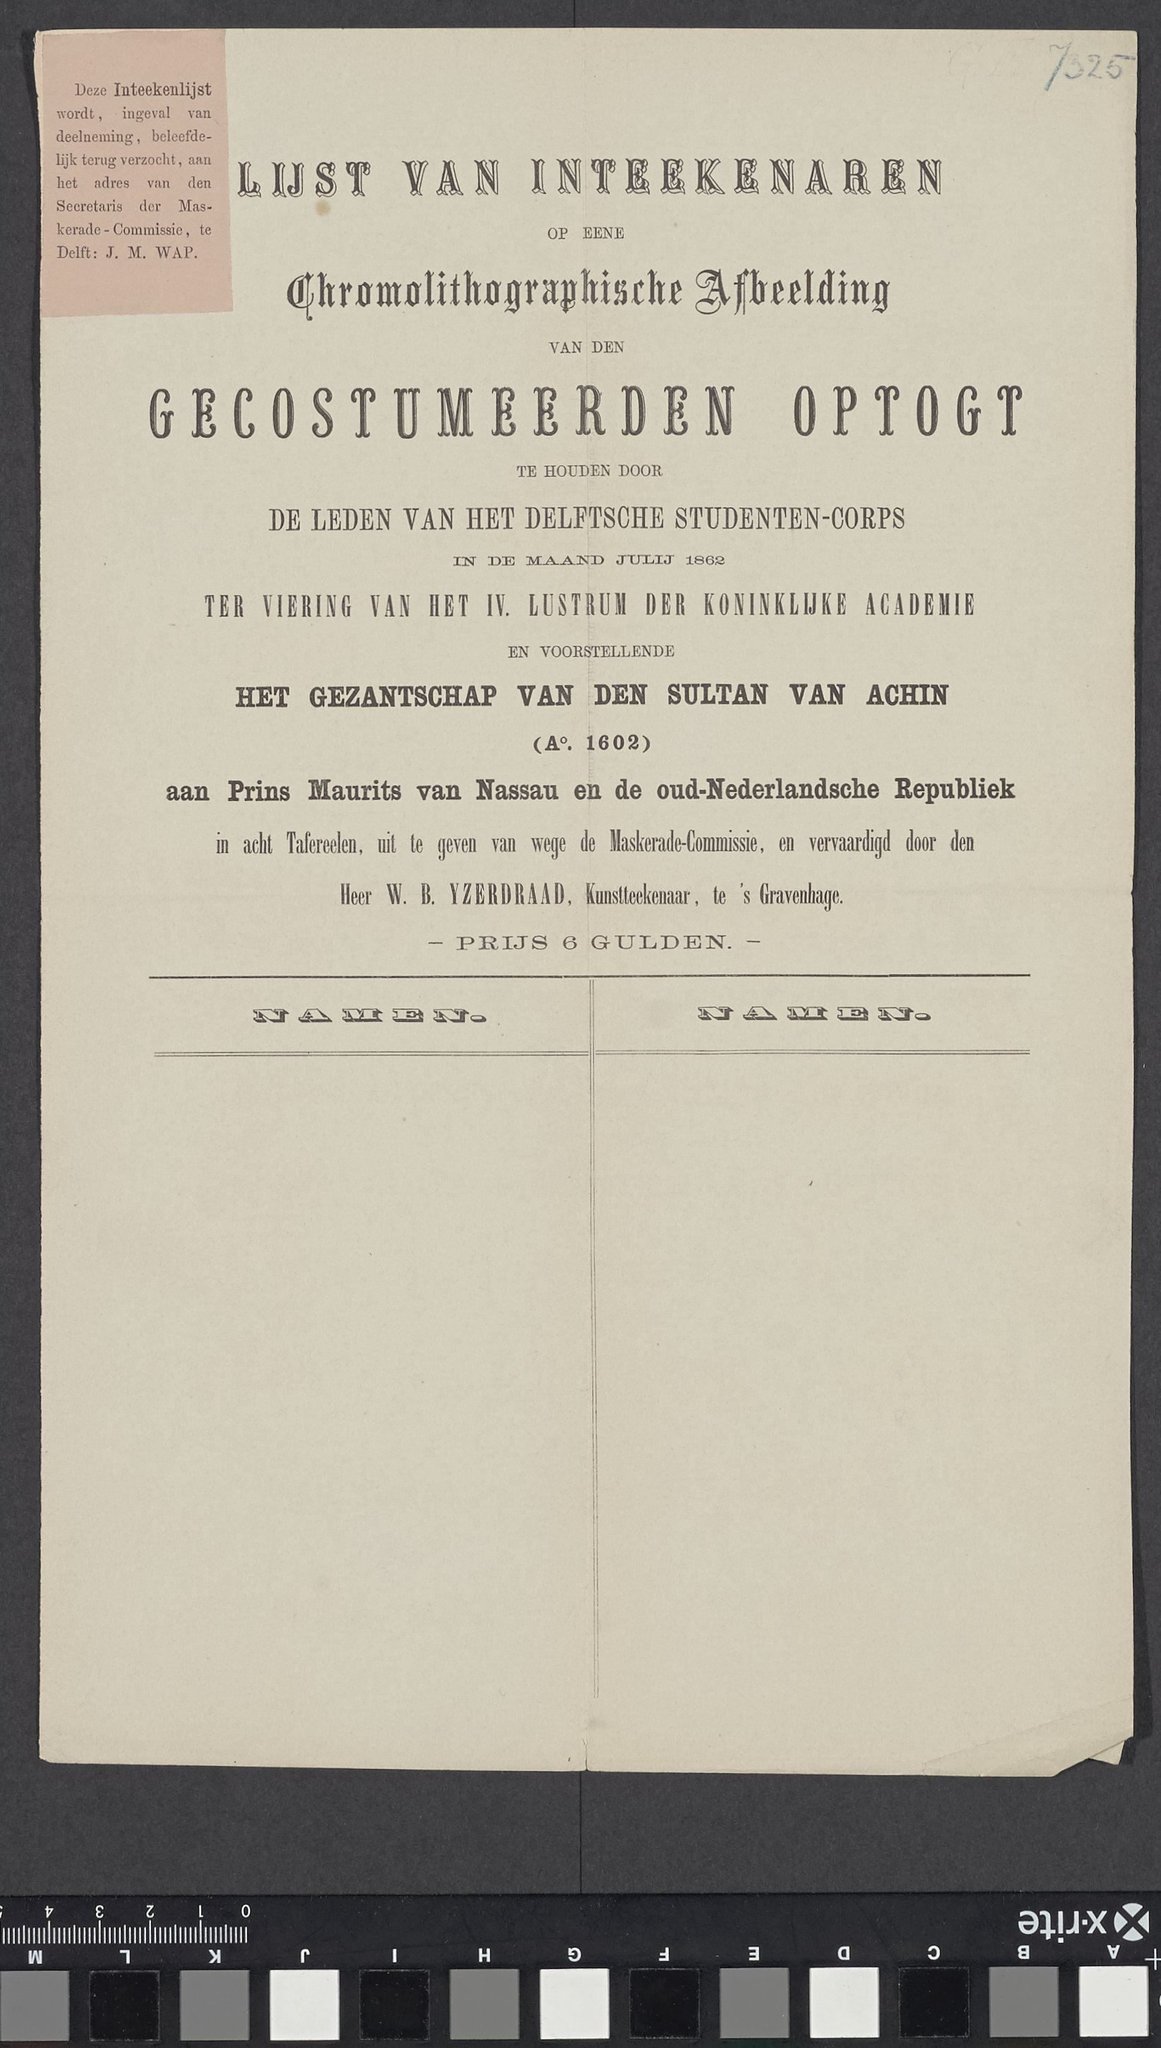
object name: text sheet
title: Vierde Lustrum der Koninklijke Academie te Delft - Ao. 1862 - Gekostumeerde Optogt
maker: Anonymous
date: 1862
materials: paper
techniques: letterpress printing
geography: netherlands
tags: university, students' pageant, commemoration of the founding of a university, delft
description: Blanco lijst van intekenaren. Behorend bij de serie van acht platen van de gekostumeerde optocht gehouden door de studenten van de Koninklijke Academie te Delft bij het vierde lustrum op 8 juni 1862.